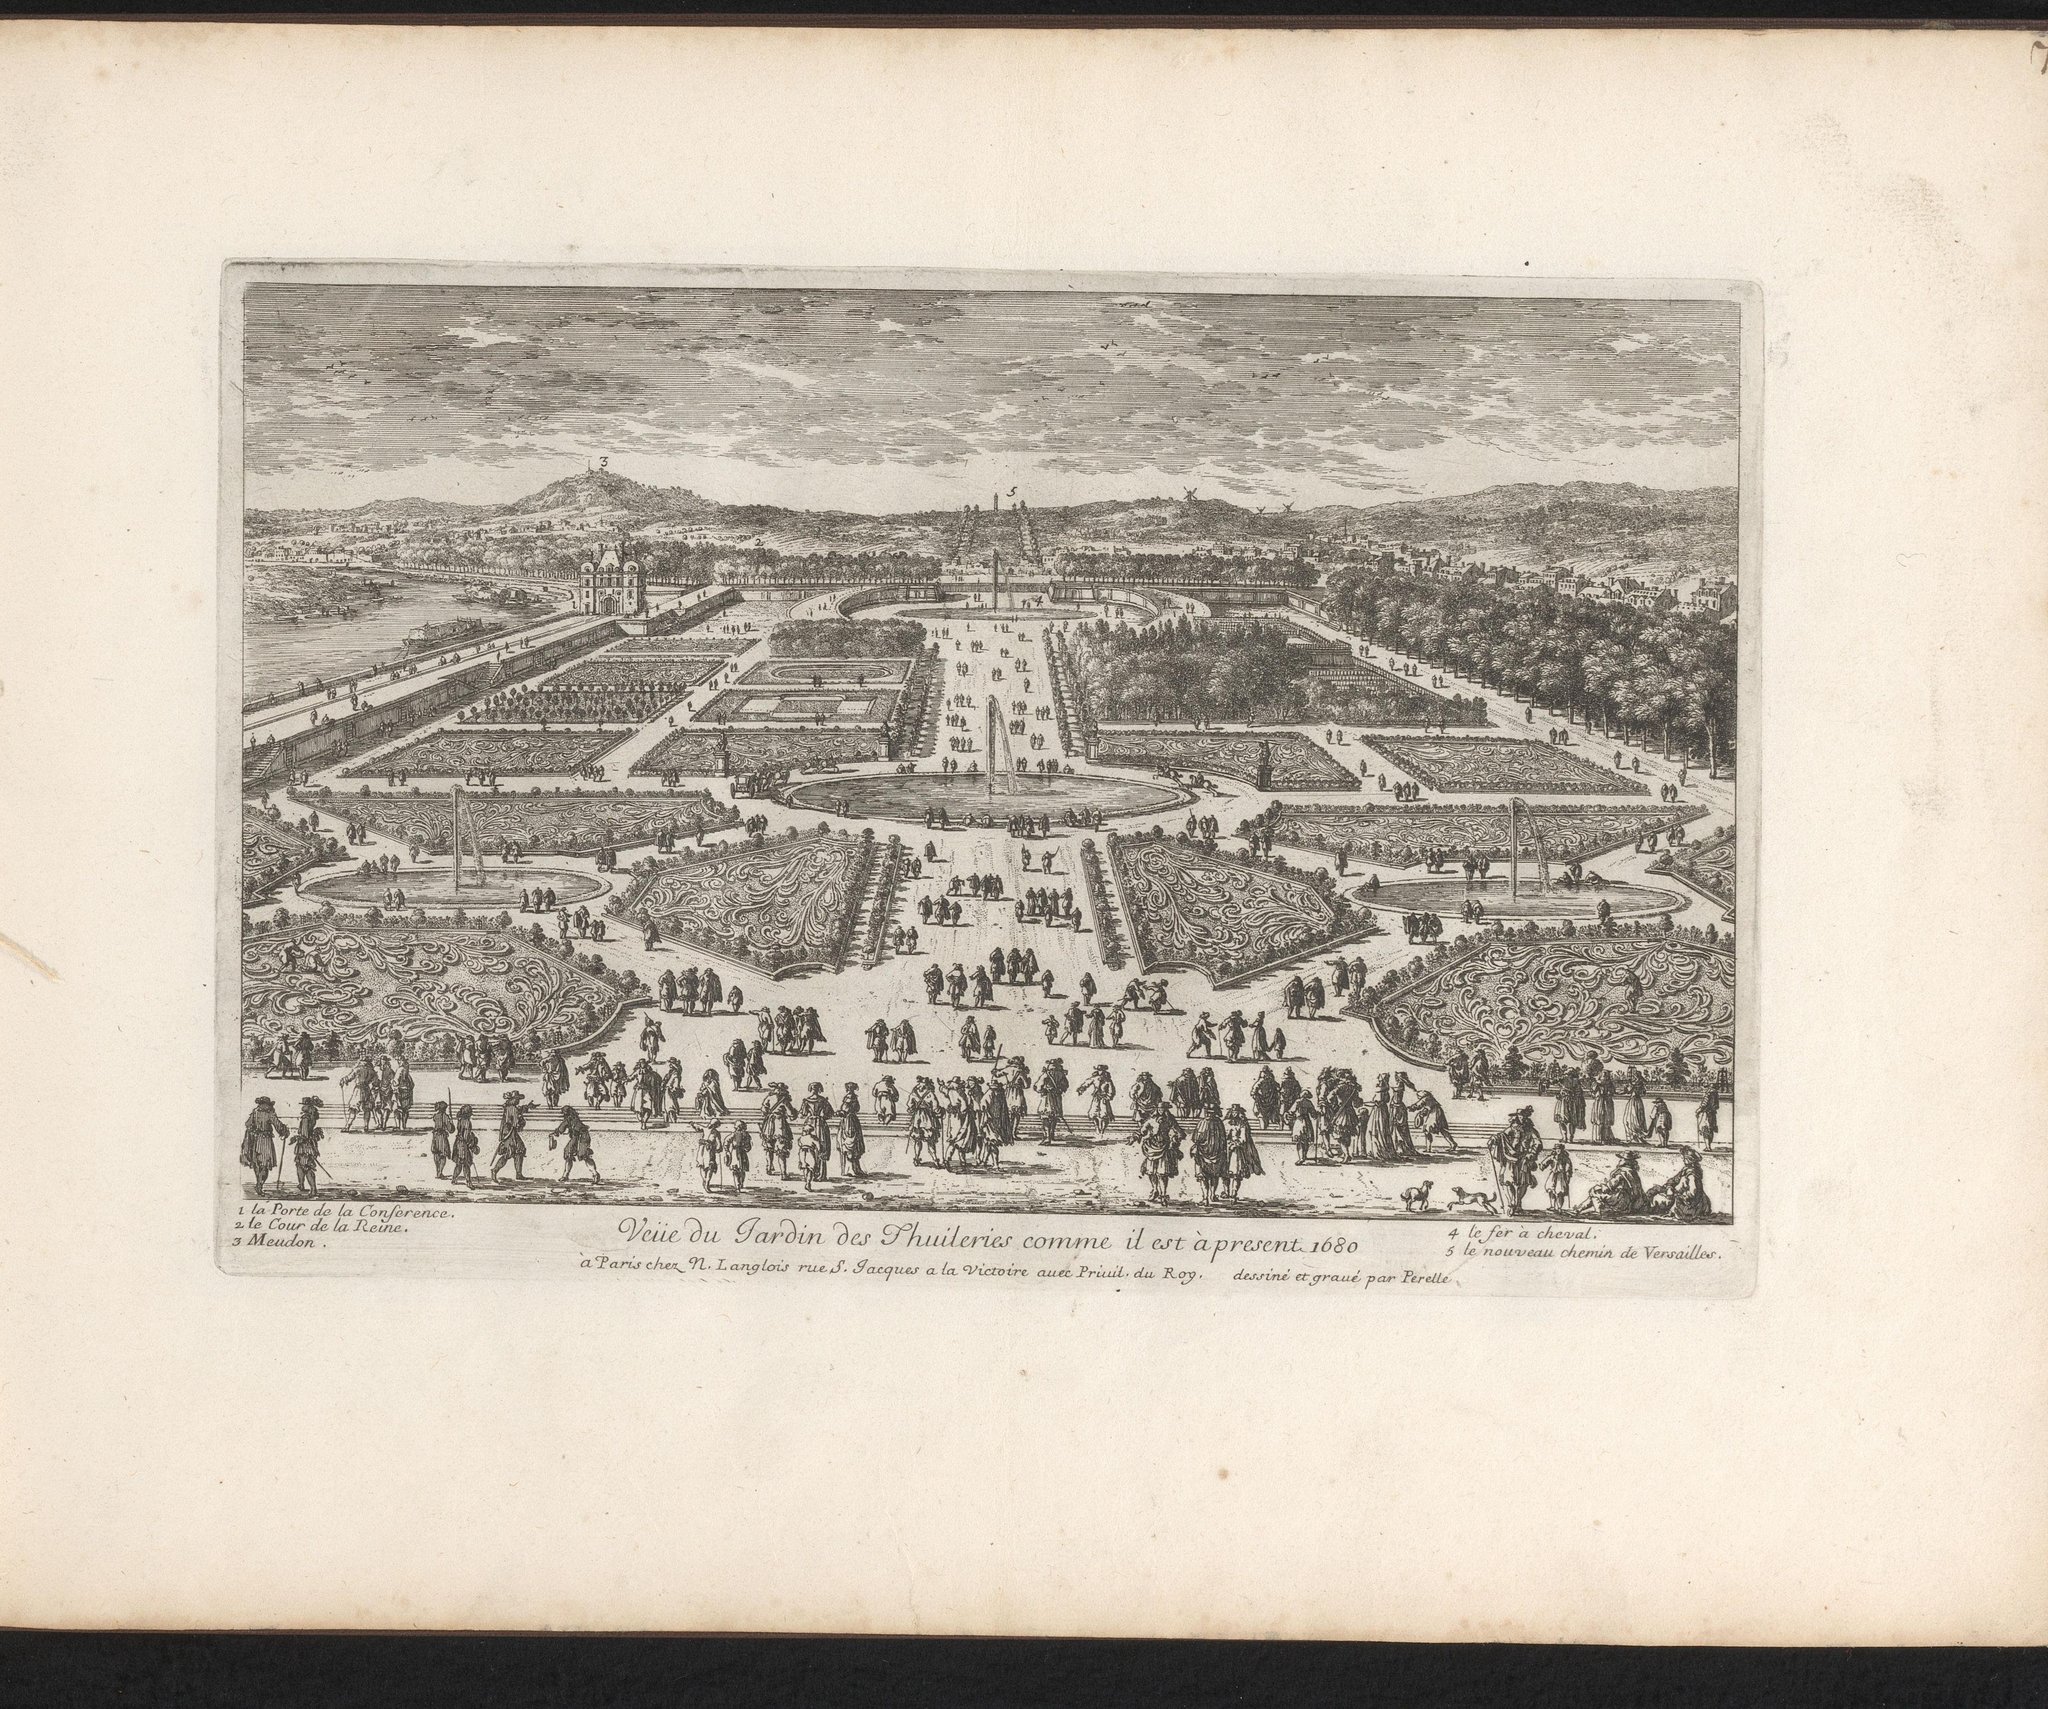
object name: print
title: Recueil de vues de monuments de Paris, des principales résidences royales et des principaux châteaux de France et de Rome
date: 1660-1695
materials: paper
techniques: etching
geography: paris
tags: french or architectonic garden; formal garden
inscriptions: collector's mark: Lugt 2228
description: Prenten met het signatuur 'Perelle' kunnen zowel door vader Gabriel als door zonen Nicolas en Adam gemaakt zijn. De uitgevers vader en zoon Nicolas Langlois worden allebei vermeld als N. Langlois op hetzelfde adres.